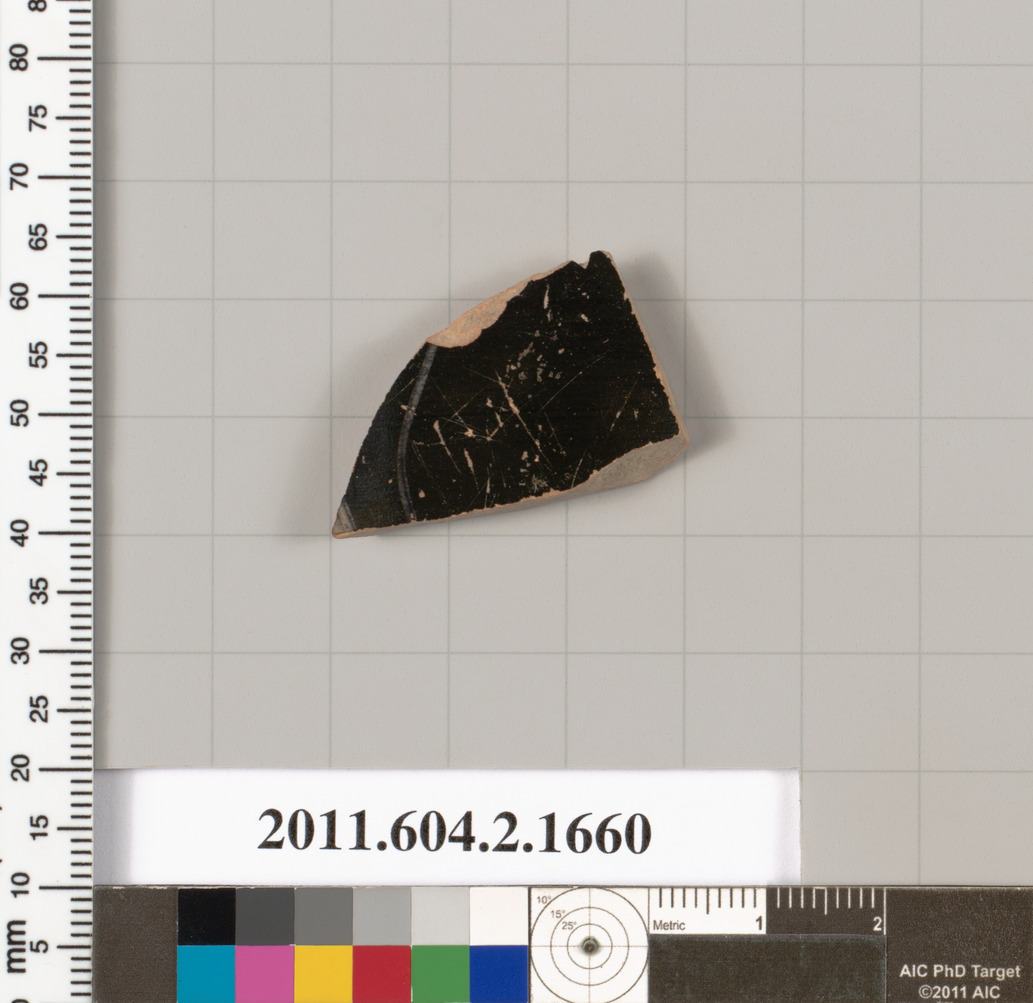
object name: skyphos fragment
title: Terracotta fragment of a skyphos (deep drinking cup)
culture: greek, attic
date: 475-400 BCE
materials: terracotta